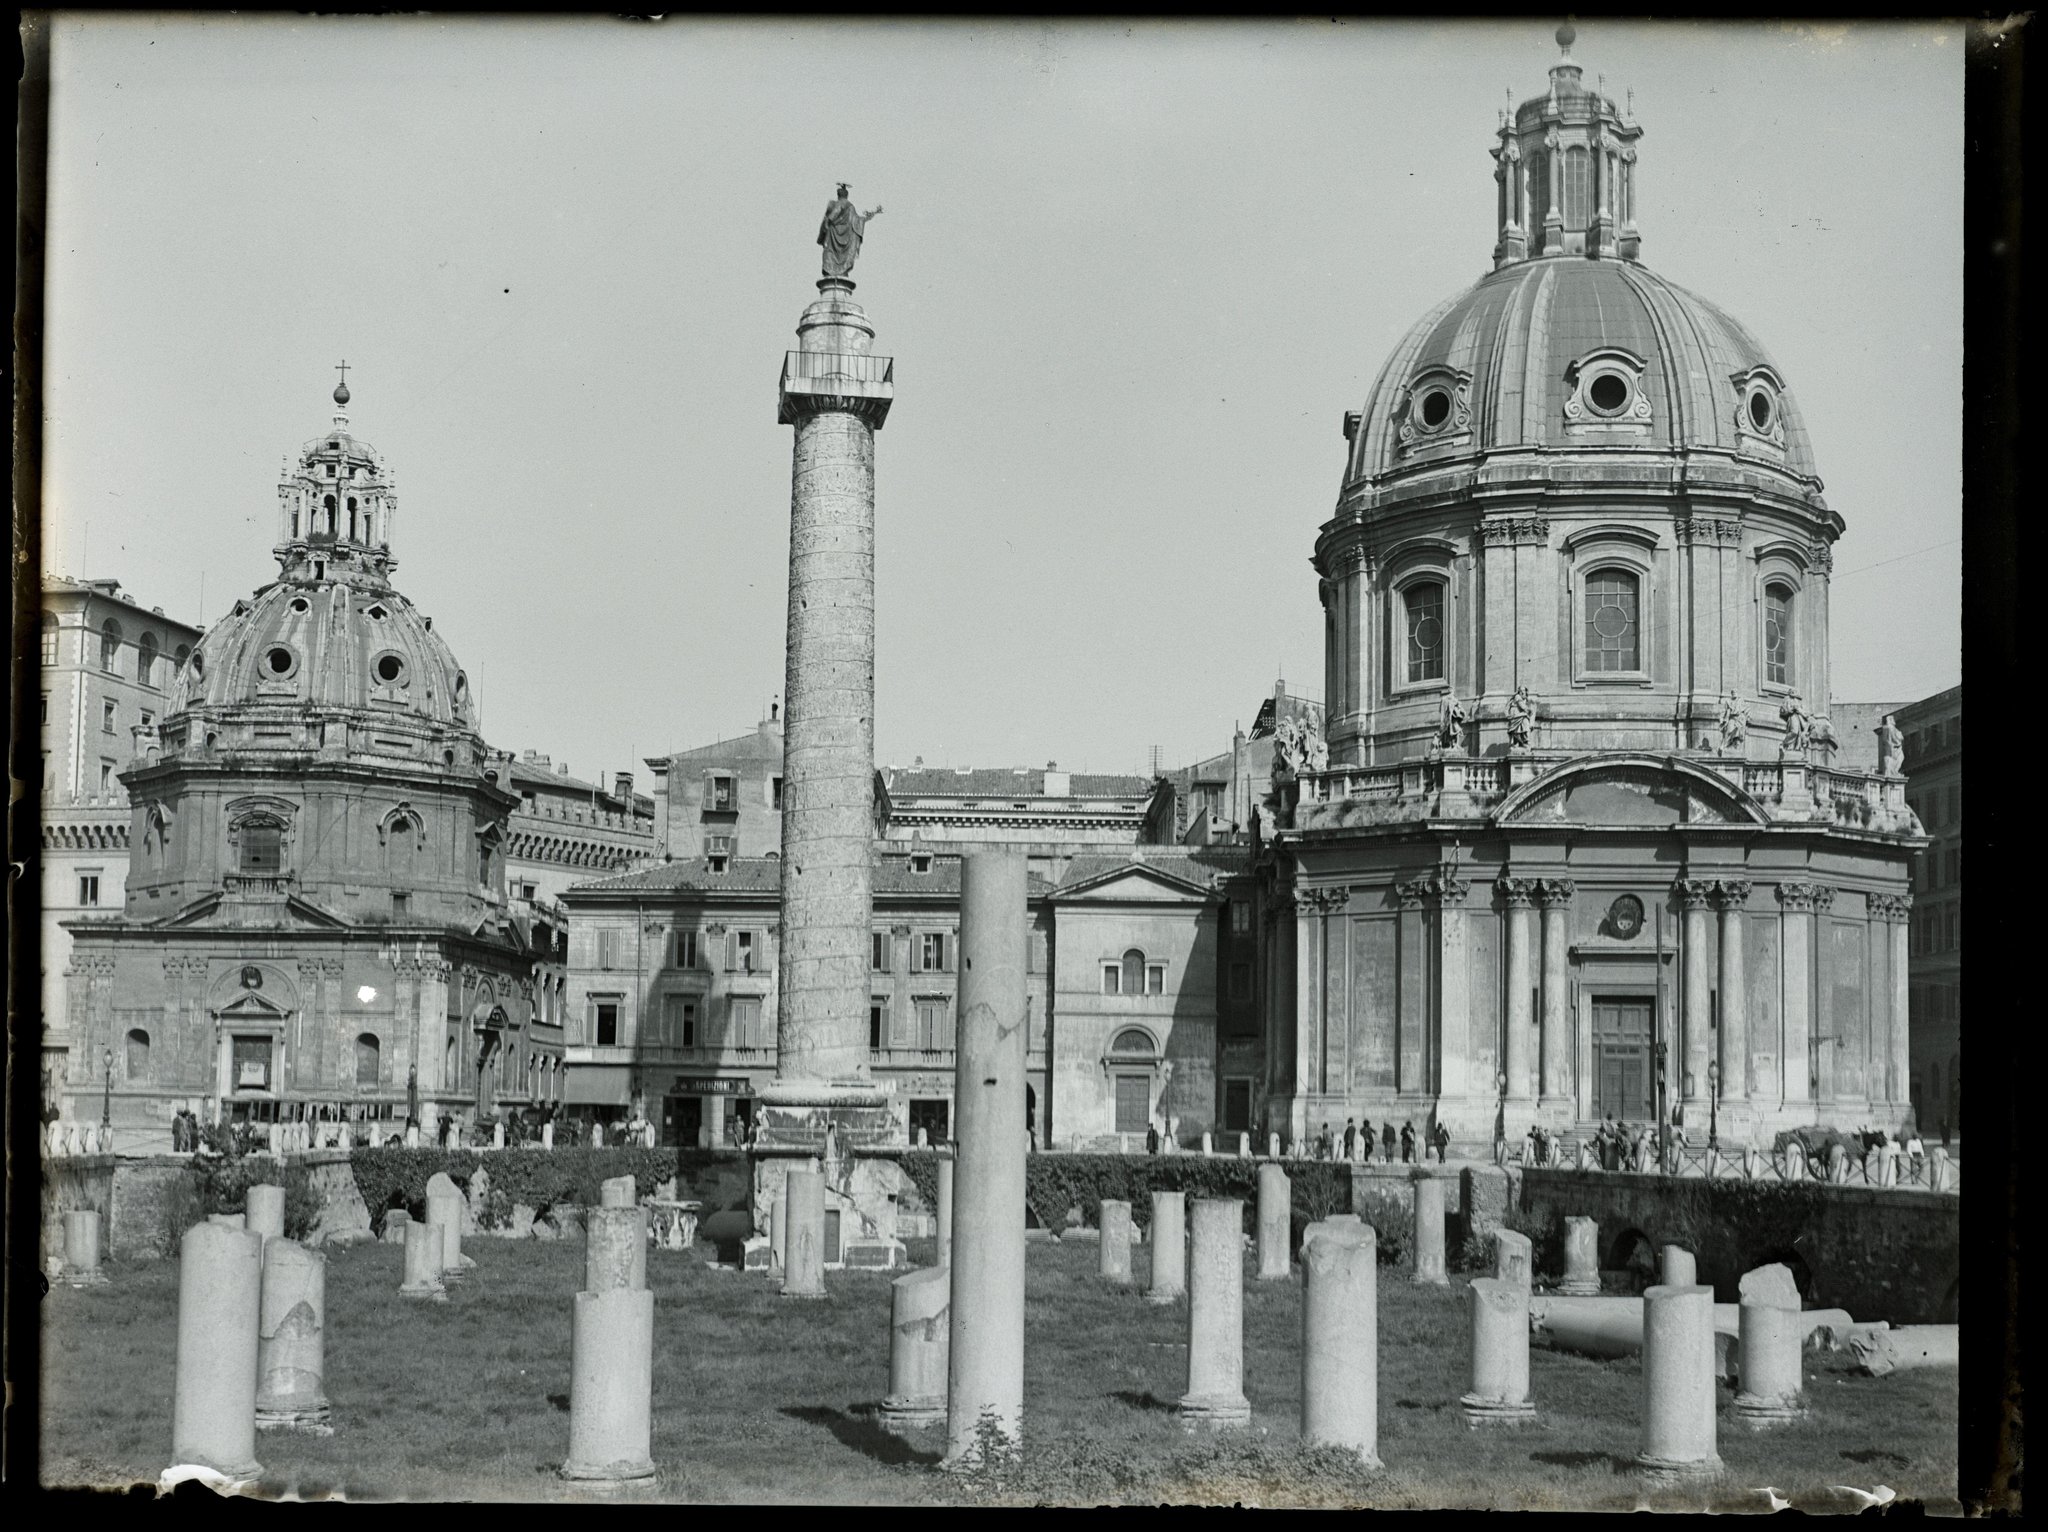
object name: glasnegatief, glasplaatnegatief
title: Gezicht op het Forum van Trajanus met links de Santa Maria di Loreto en rechts de Santissimo Nome di Maria al Foro Traiano te Rome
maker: Anonymous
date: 1907-1935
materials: glass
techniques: gelatin glass negative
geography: italy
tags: square, place, circus, etc., column, pillar ~ architecture, parts of church exterior and annexes: dome